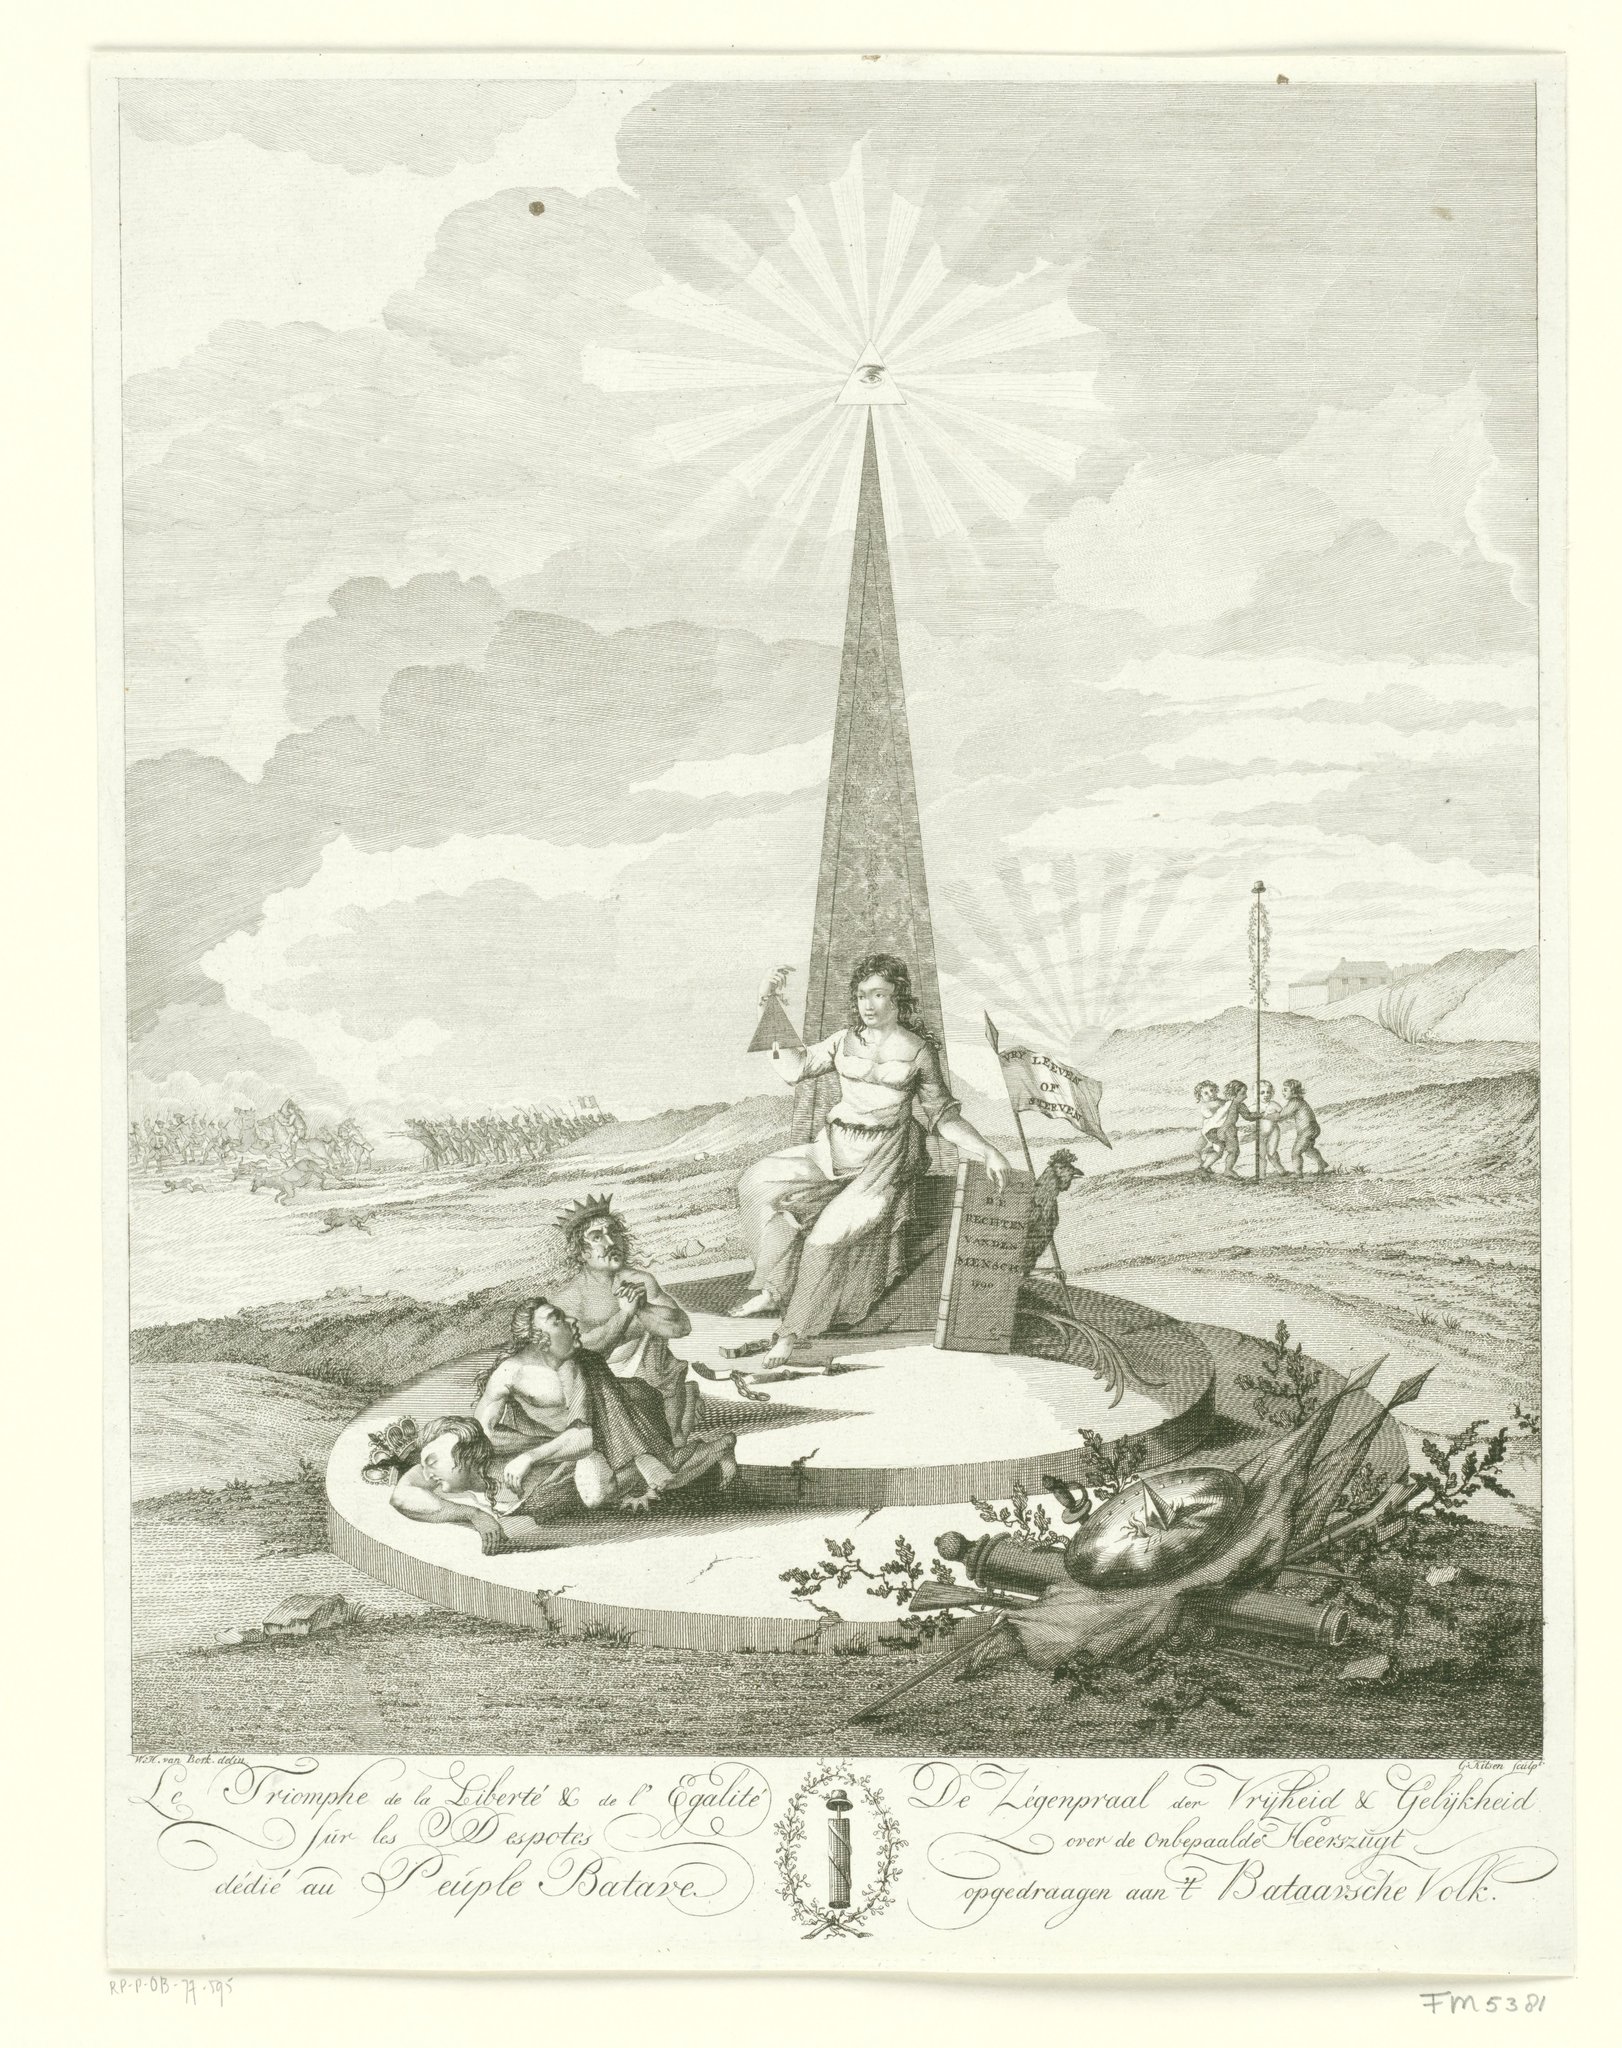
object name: print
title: Le Triomphe de la Liberté et de l'Egalité sur les Despots dédié au Peuple Batave / De Zégenpraal der Vrijheid & Gelijkheid over de onbepaalde Heerszugt opgedraagen aan 't Bataavsche Volk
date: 1795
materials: paper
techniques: engraving, etching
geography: netherlands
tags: the hague, william v (prince of orange), lodewijk xvi (koning van frankrijk), equality, equity, fairness, righteousness; 'equalità', 'equità', 'giuditio giusto', 'ordine dritto e giusto', 'ugualità' (ripa) (+ abstract concept represented by female figure), head of a beheaded person, battle (+ land forces), freedom, liberty; 'libertà' (ripa) (+ abstract concept represented by female figure)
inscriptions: collector's mark: Lugt 2228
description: Allegorie met triomf van Vrijheid en Gelijkheid over de Heerszucht, 1795, De Gelijkheid zit op een estrade voor een obelisk (bekroond door het Alziende Oog), haar hand rustend op het boek met de Rechten van de Mens. Op de voorgrond stadhouder Willem V, een smekende koning en het afgehouwen hoofd van Lodewijk XVI. Linksachter verjaagt het Franse leger de vijand, rechtsachter dansen naakte kinderen rond een vrijheidsboom en een zonsopkomst.